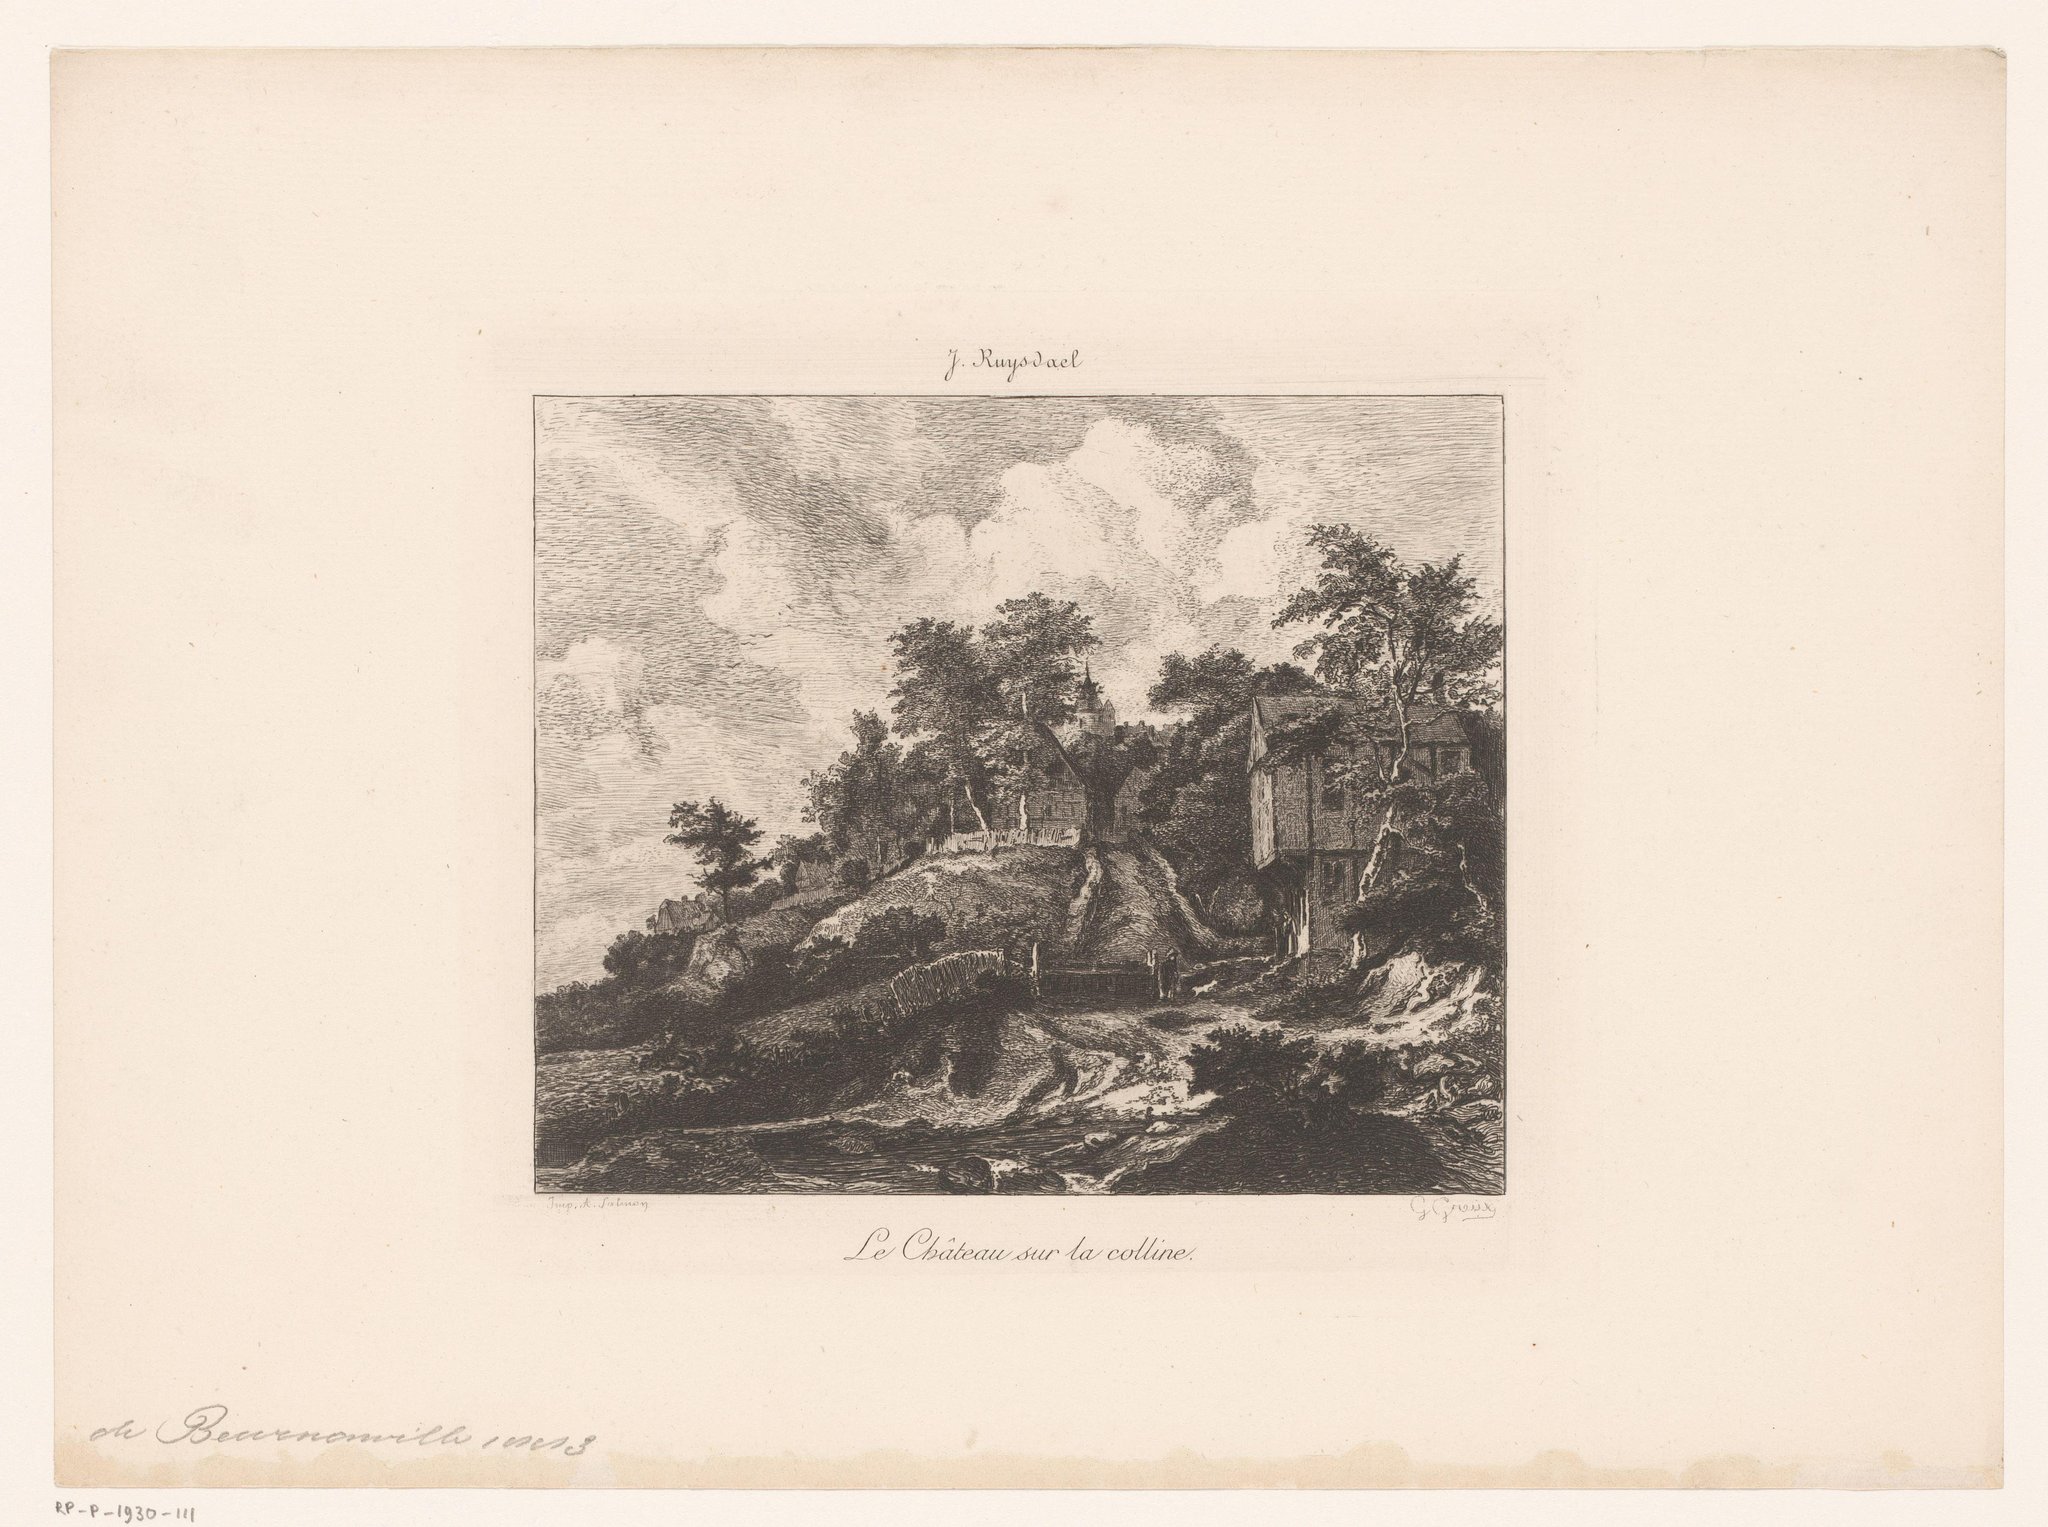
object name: print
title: Heuvelachtig landschap met een kasteel en een boerenwoning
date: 1881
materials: paper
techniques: etching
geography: paris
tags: castle, (high) hill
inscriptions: collector's mark: Lugt 2228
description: Prent afkomstig uit een veilingcatalogus: "Catalogue des Tableaux anciens composant la très importante collection de Monsieur le Baron de Beurnonville", uitgegeven in 1881 te Parijs door Pillet en Dumoulin. De veiling vond plaats op 9 tot en met 14 en 16 mei 1881.